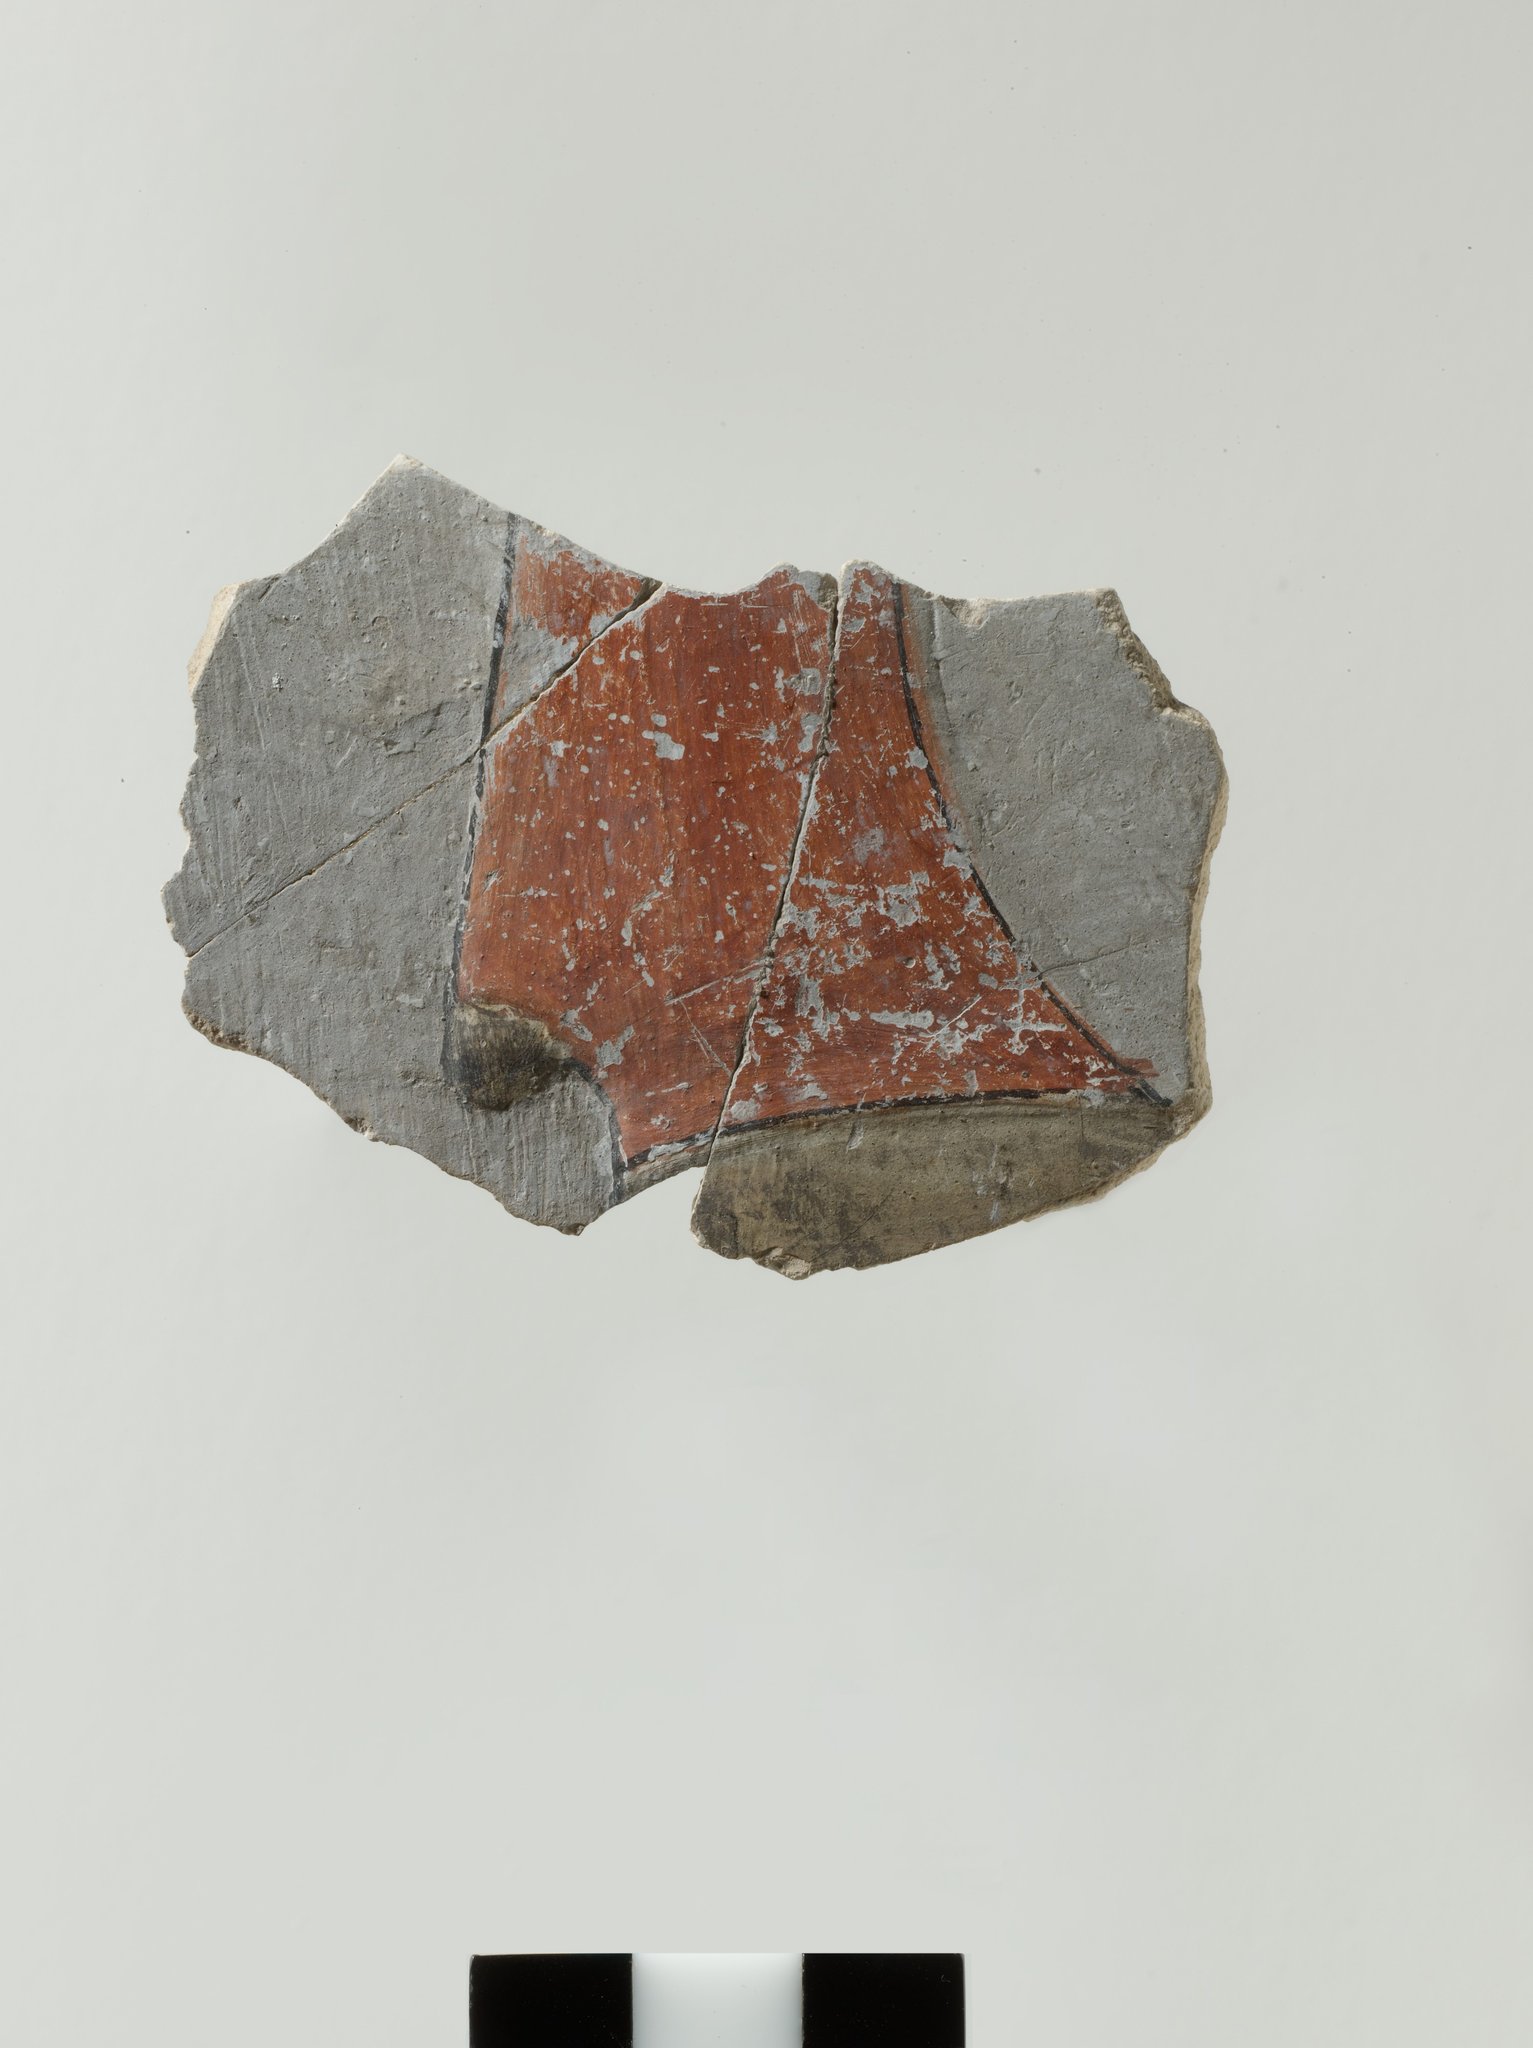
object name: relief fragment, tomb of meketre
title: Relief fragment from tomb of Meketre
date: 1981-1975 BCE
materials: limestone, paint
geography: egypt